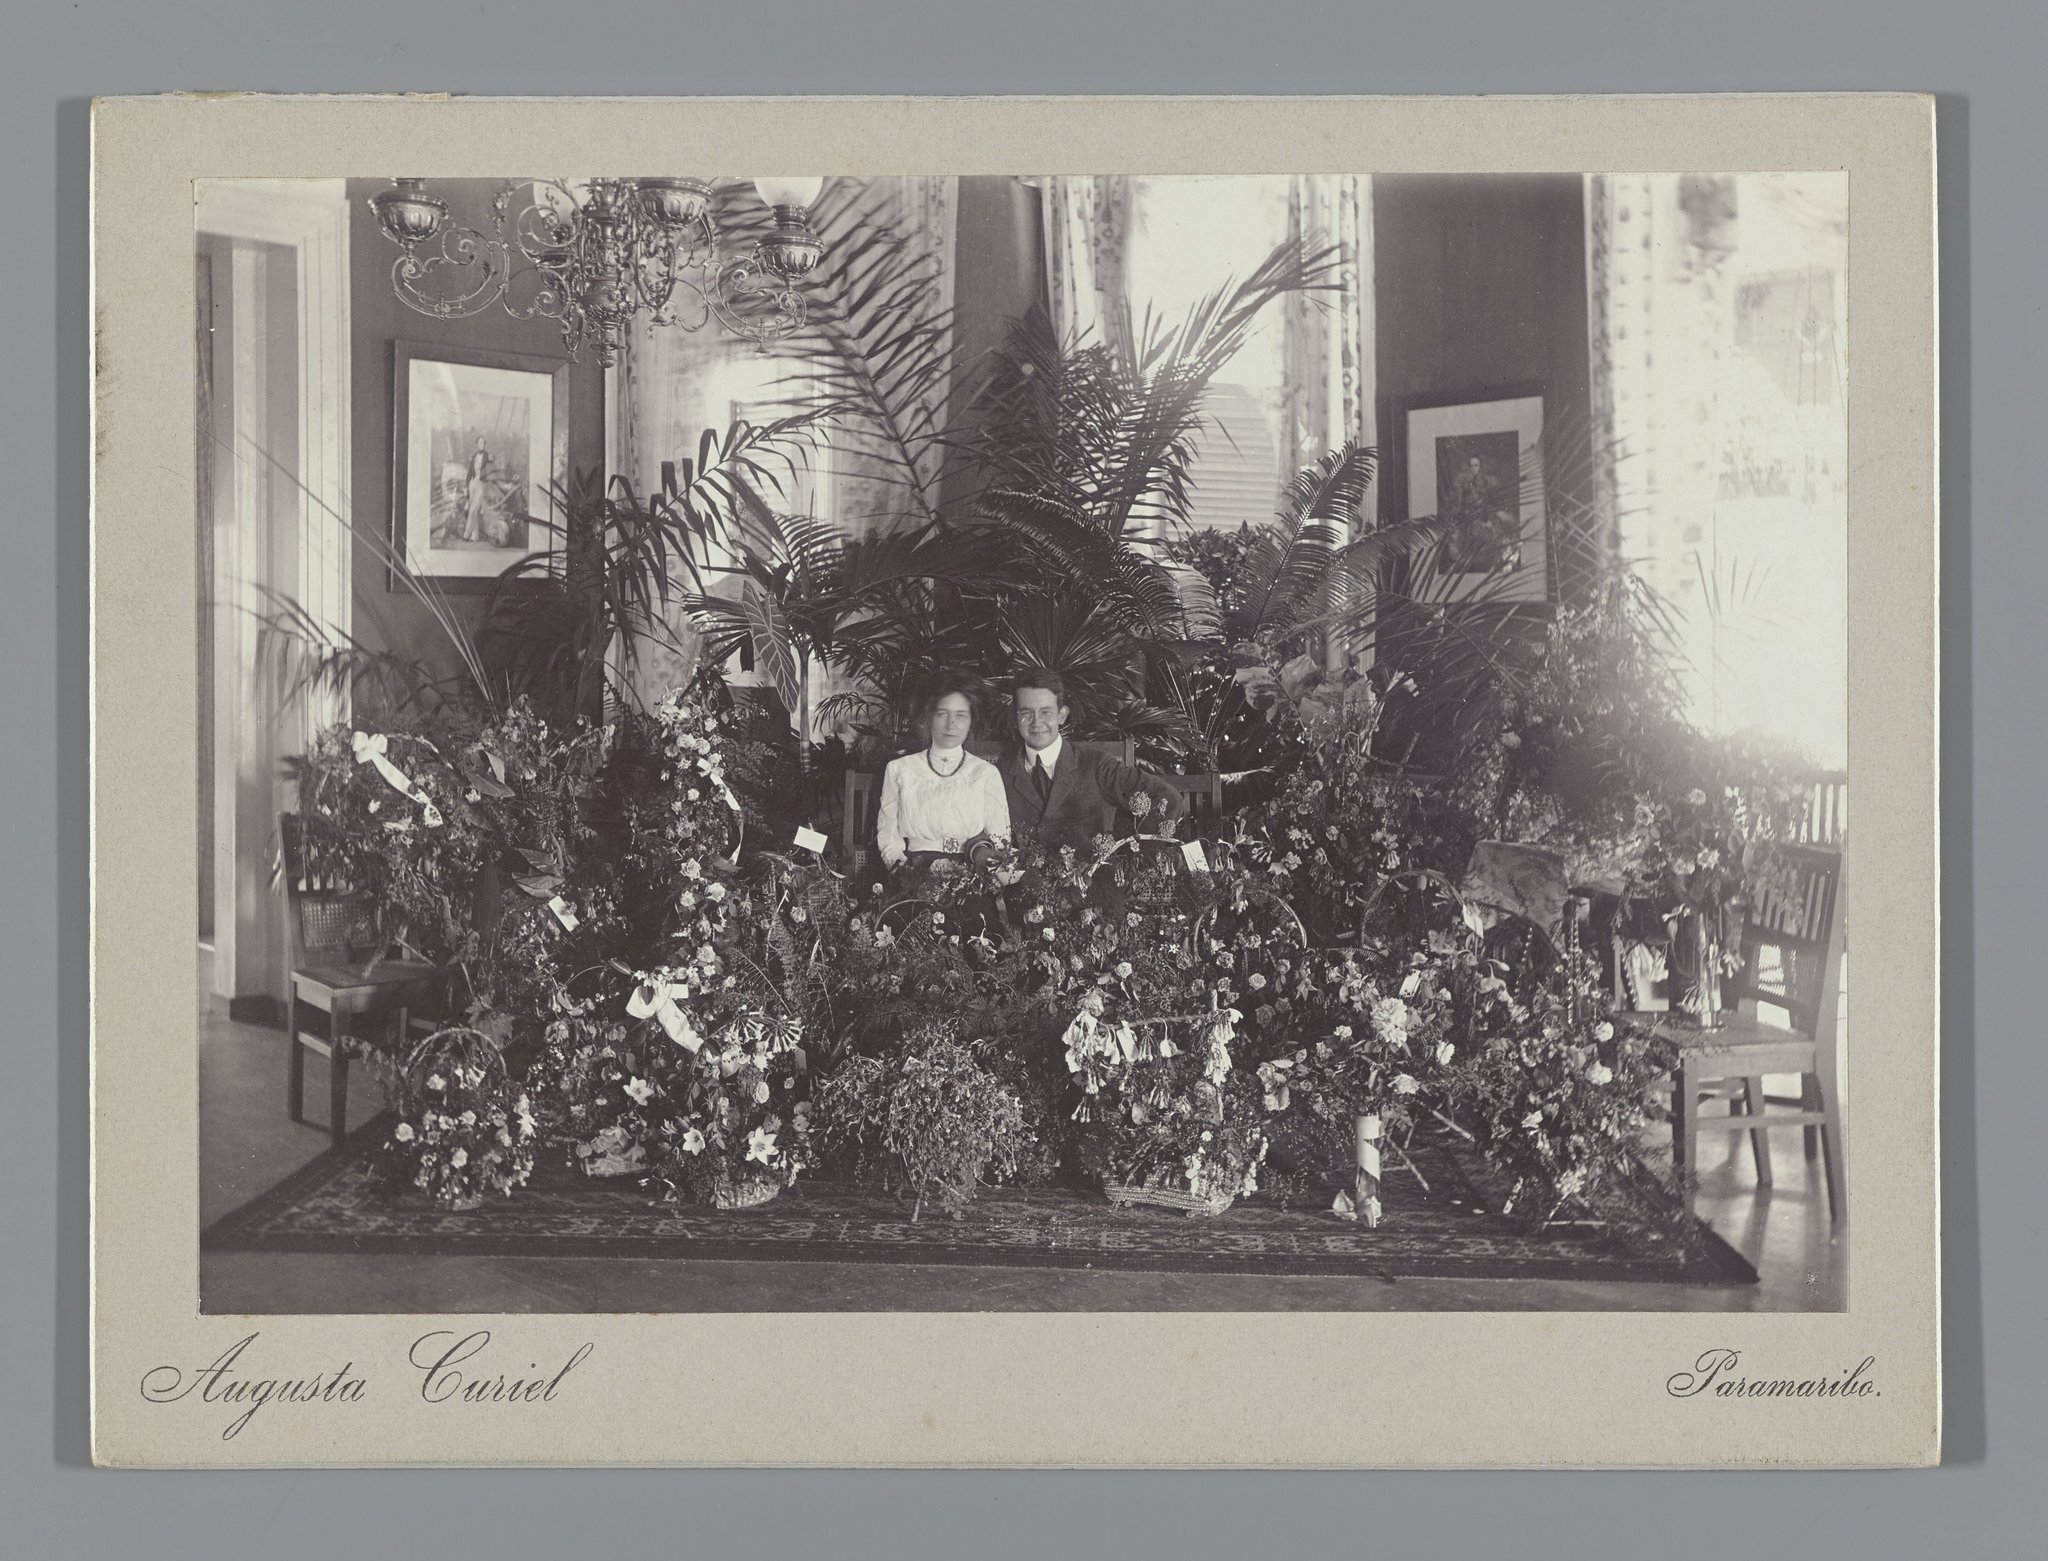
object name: photograph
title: Jong stel zittend tussen boeketten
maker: augusta curiel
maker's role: fotograaf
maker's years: 1873-1937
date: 1905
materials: paper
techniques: photography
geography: paramaribo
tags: suriname